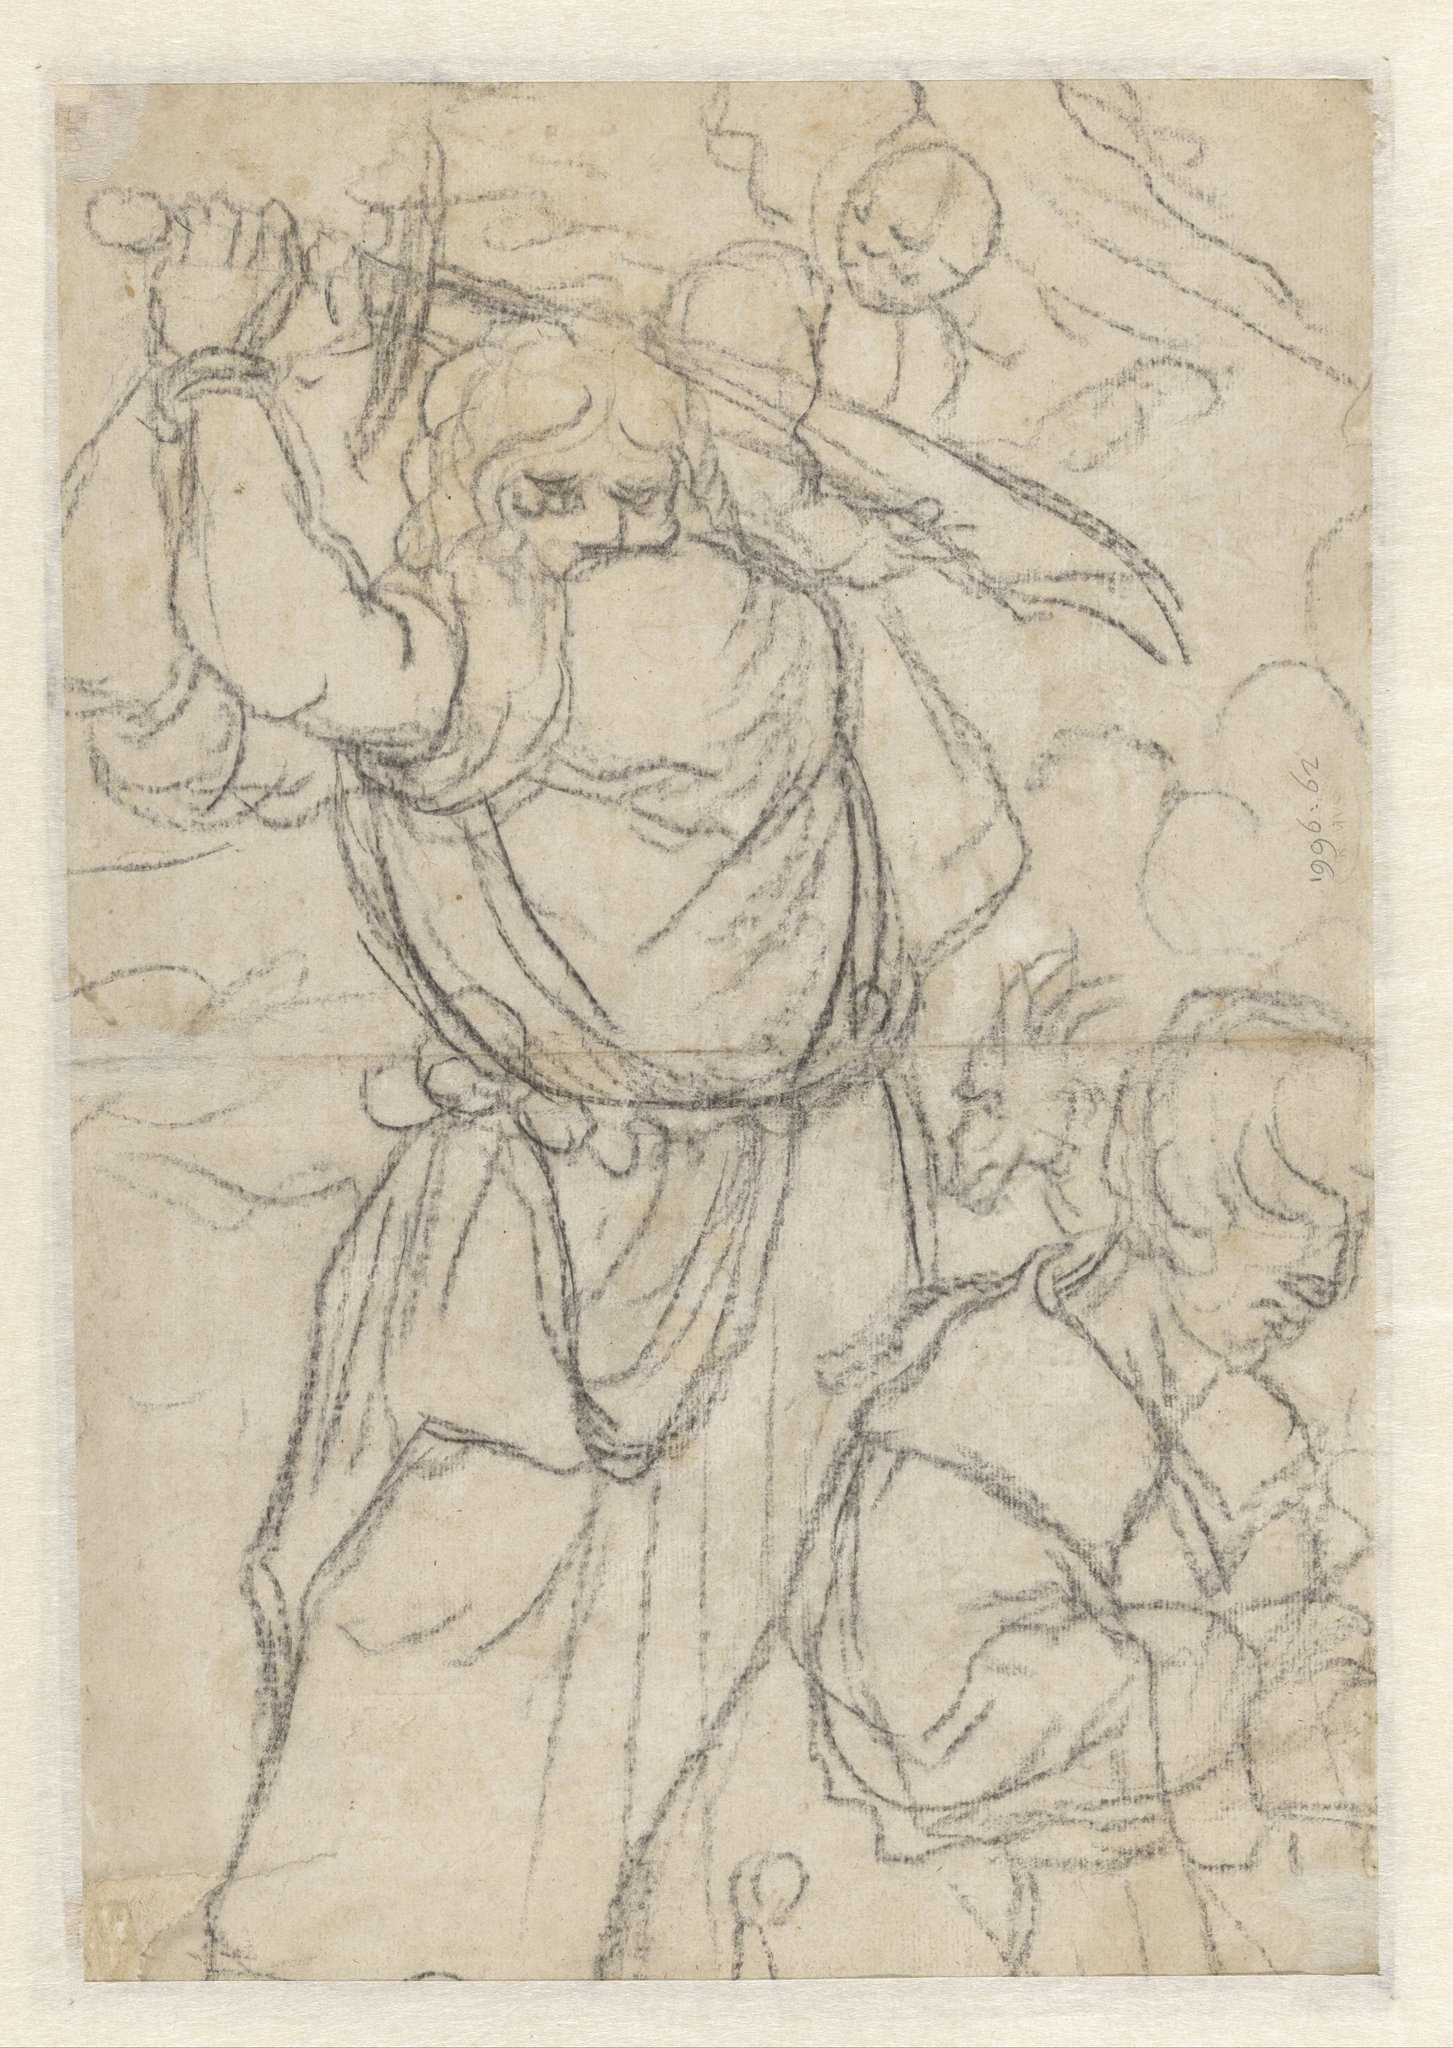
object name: drawing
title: Offer van Abraham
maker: Anonymous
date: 1530-1540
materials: ink, paper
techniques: brush, pen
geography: southern netherlands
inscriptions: inscription: ‘bovenaan genummerd: ..426; onderaan een onleesbaar geworden opschrift’